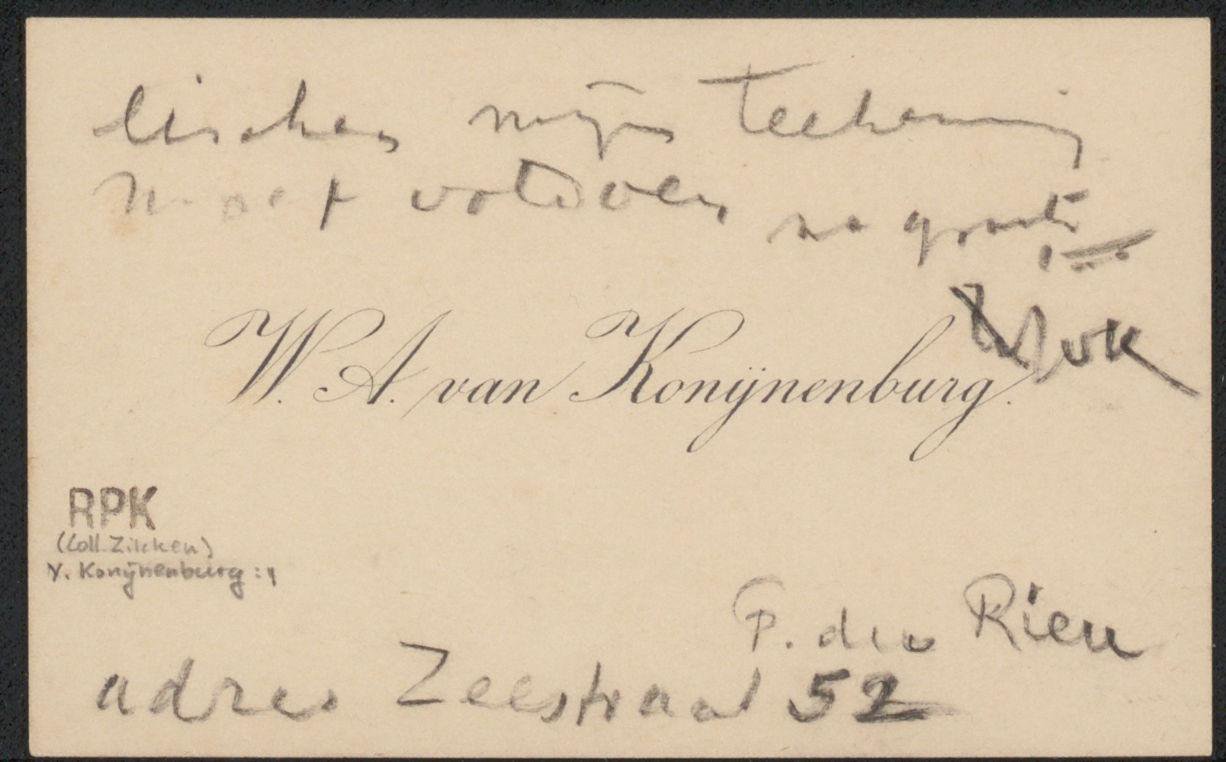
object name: visiting card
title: Visitekaartje aan Philip Zilcken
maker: willem van konijnenburg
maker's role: draughtsman, painter, print maker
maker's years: 1868-1943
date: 1905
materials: cardboard, pencil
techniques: printing, writing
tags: the hague, painter, draughtsman, philip zilcken, drawing, music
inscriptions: collector's mark: ‘RPK’